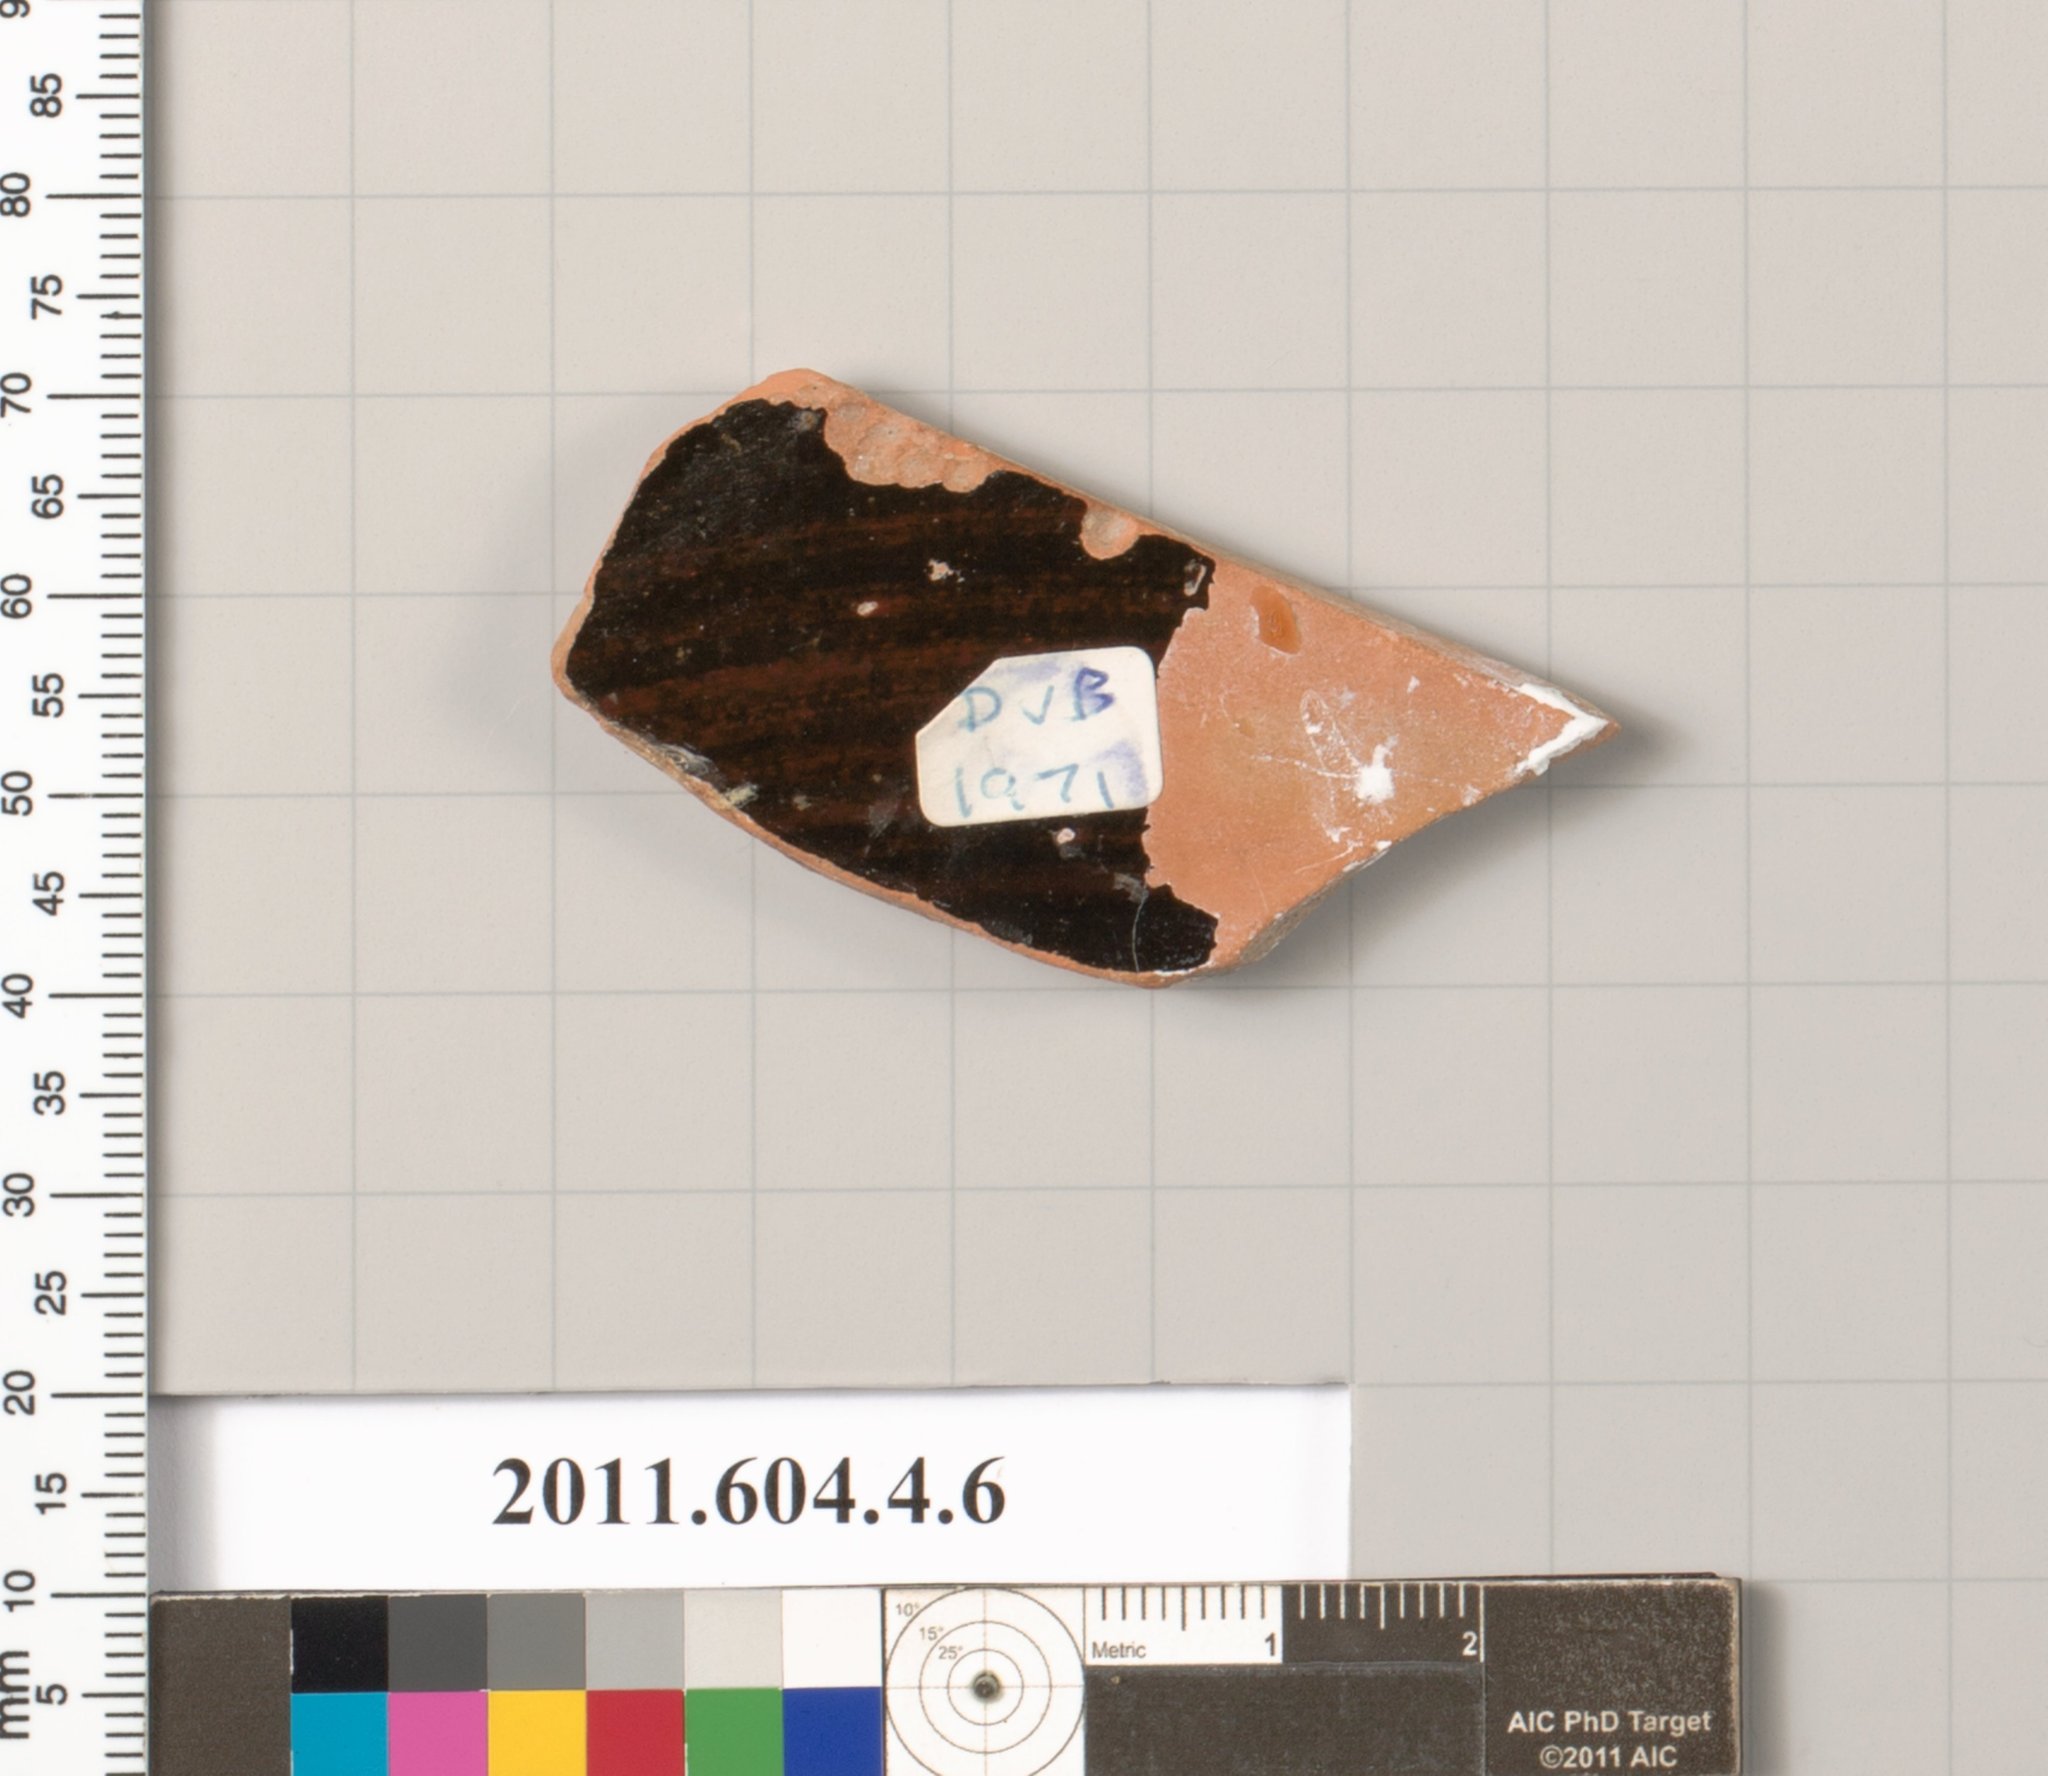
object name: kylix fragment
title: Terracotta fragment of a kylix (drinking cup)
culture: greek, attic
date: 467-435 BCE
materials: terracotta